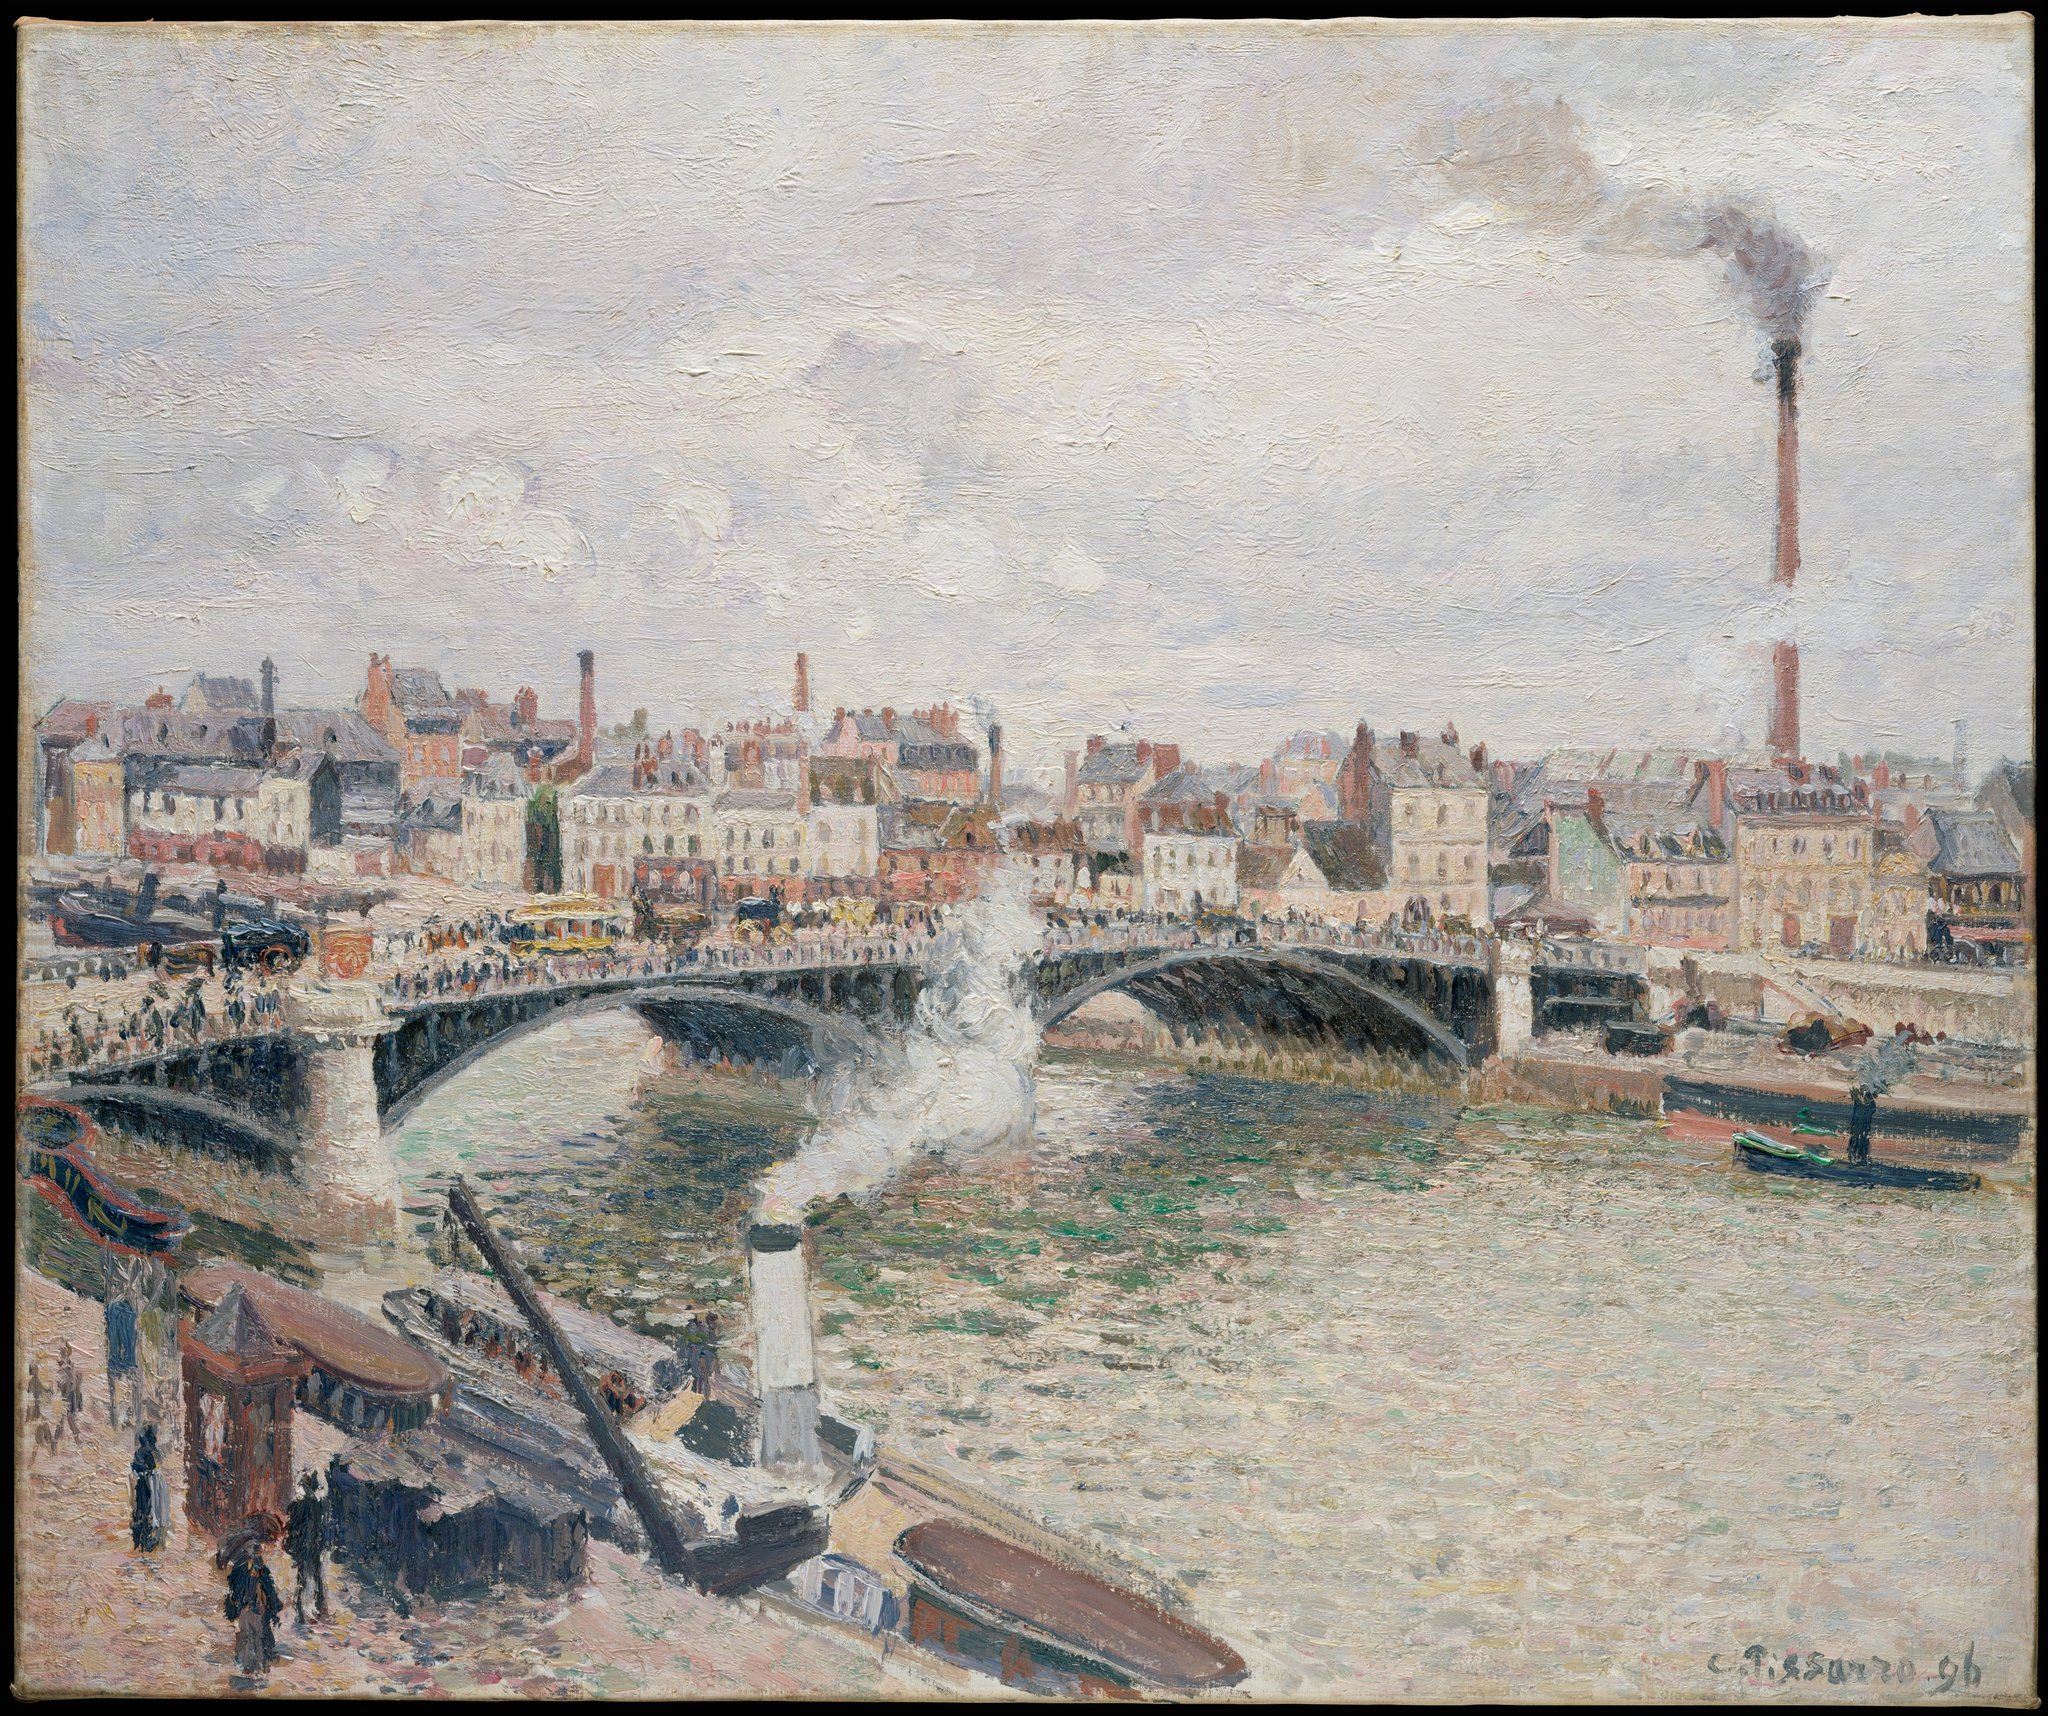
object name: painting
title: Morning, An Overcast Day, Rouen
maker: camille pissarro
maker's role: artist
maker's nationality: french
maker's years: 1830-1903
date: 1896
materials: canvas, oil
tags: cities,bridges,rivers,boats